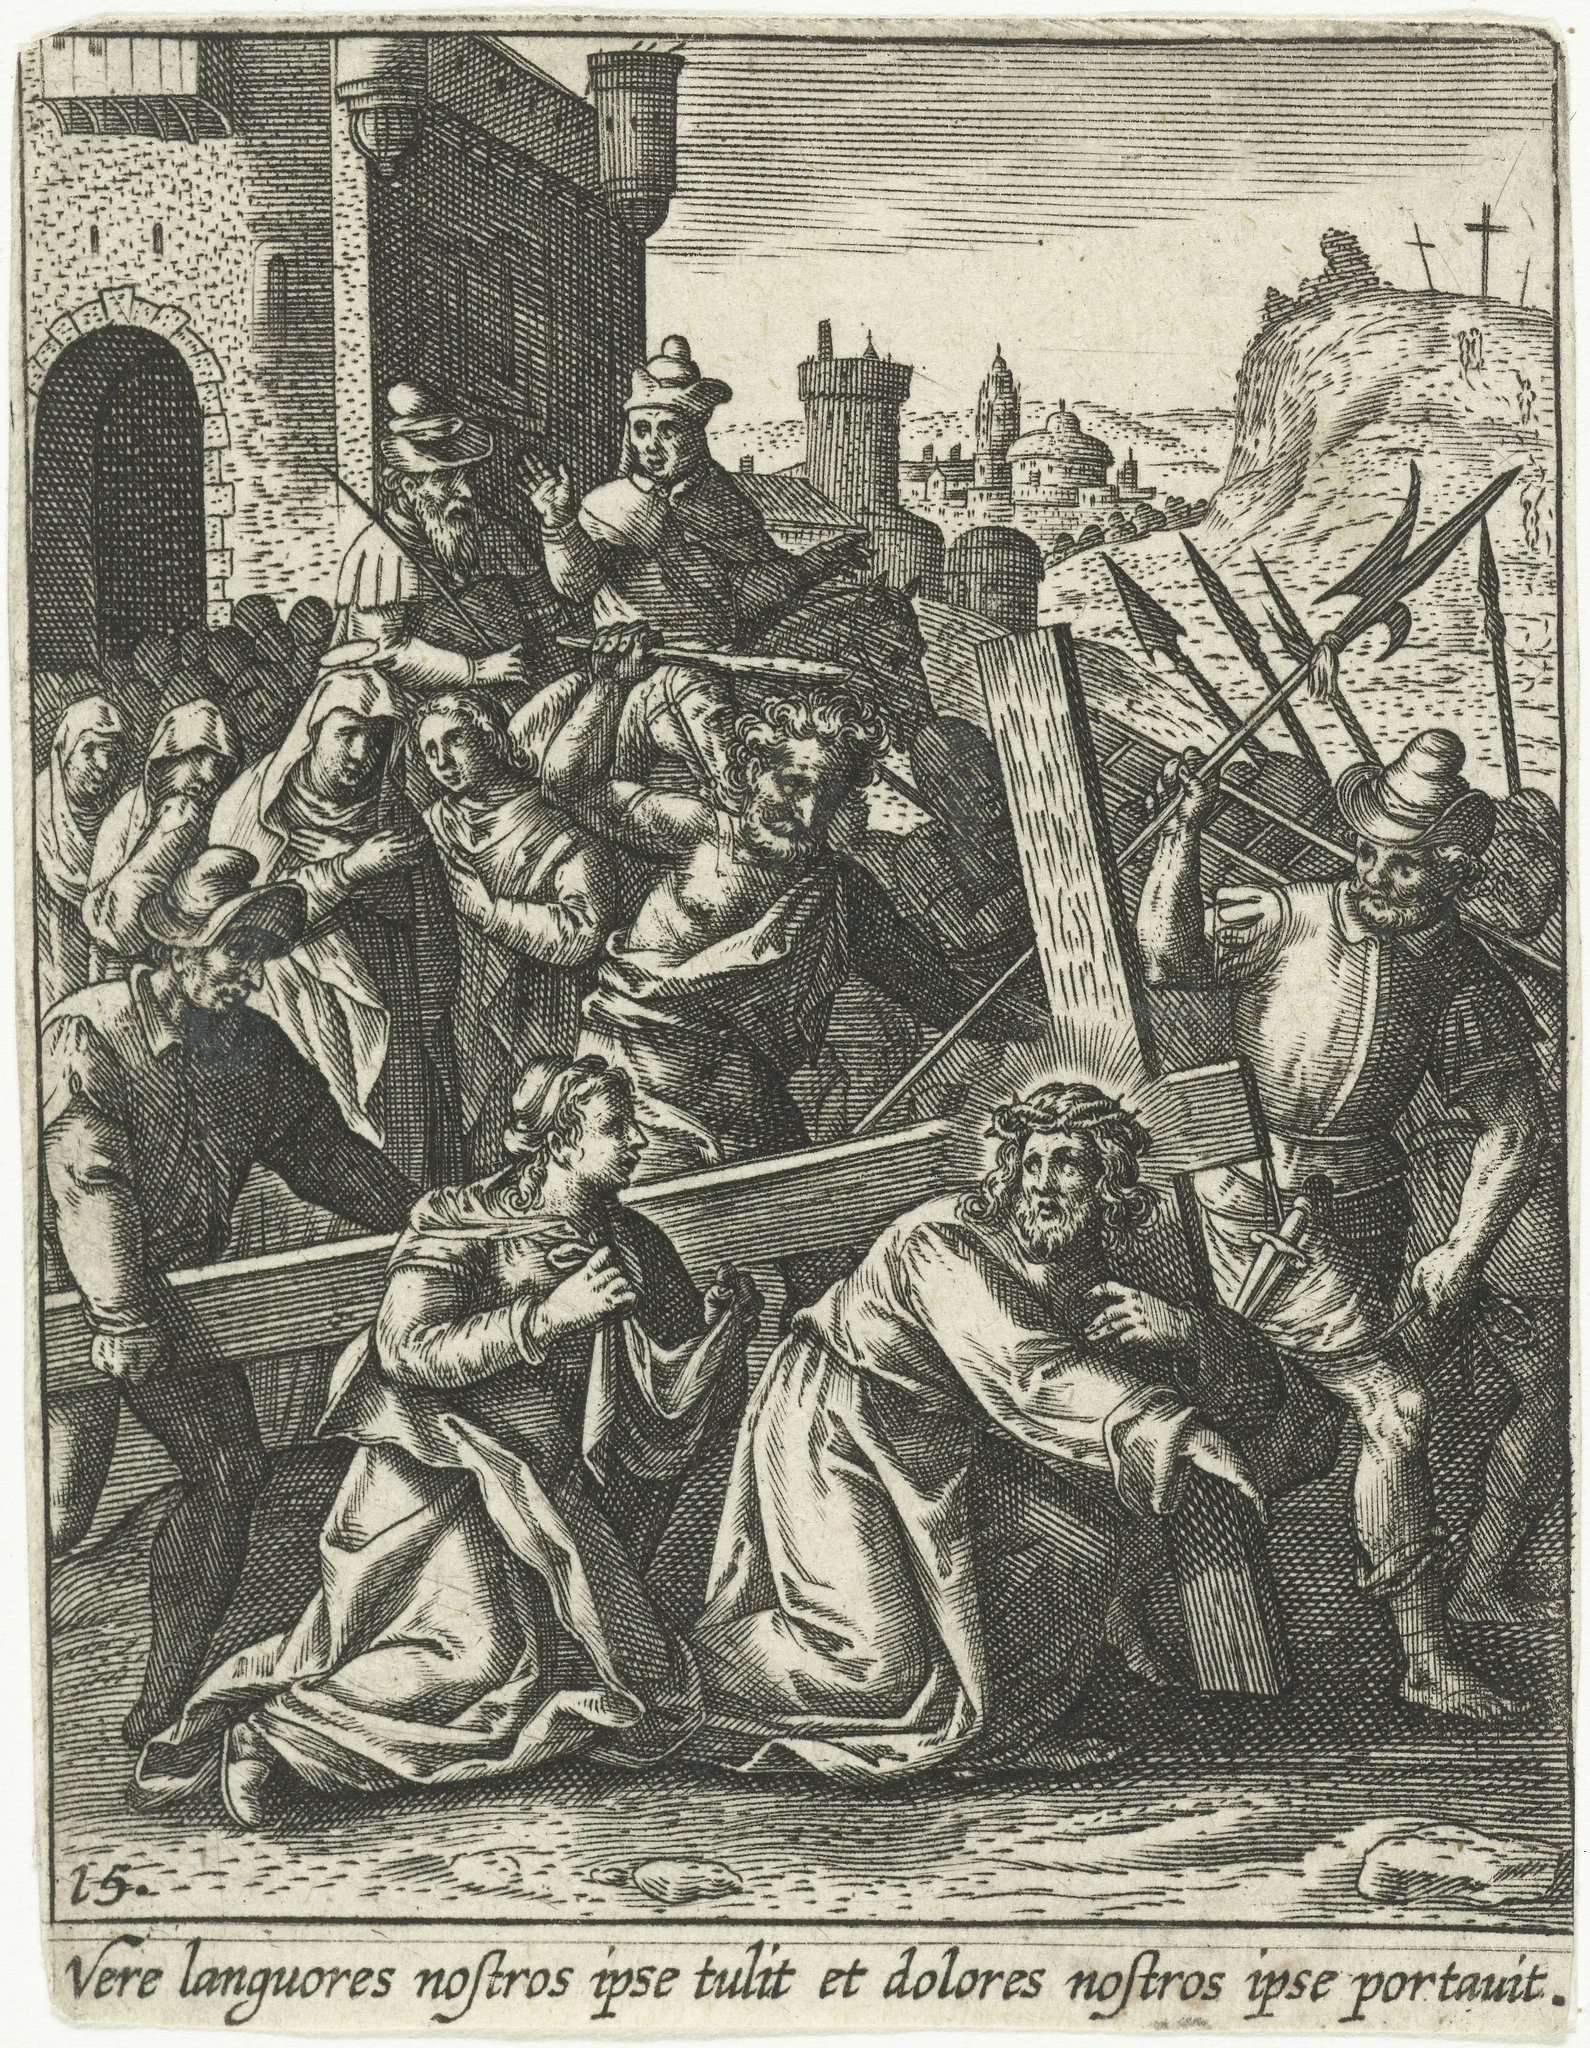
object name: print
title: Passie en wederopstanding van Christus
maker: adriaen collaert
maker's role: draughtsman, print maker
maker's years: 1560-1618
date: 1570-1618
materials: paper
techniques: engraving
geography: antwerp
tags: christ meets veronica, who has a cloth to wipe christ's face, carrying of the cross: christ bearing the cross, alone or with the help of others (e.g. simon the cyrenian)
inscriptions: collector's mark: Lugt 2228, collector's mark: Lugt 240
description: Christus valt met het kruis en Veronica biedt een doek aan om zijn zweet af te wassen. De prent heeft een Latijns onderschrift